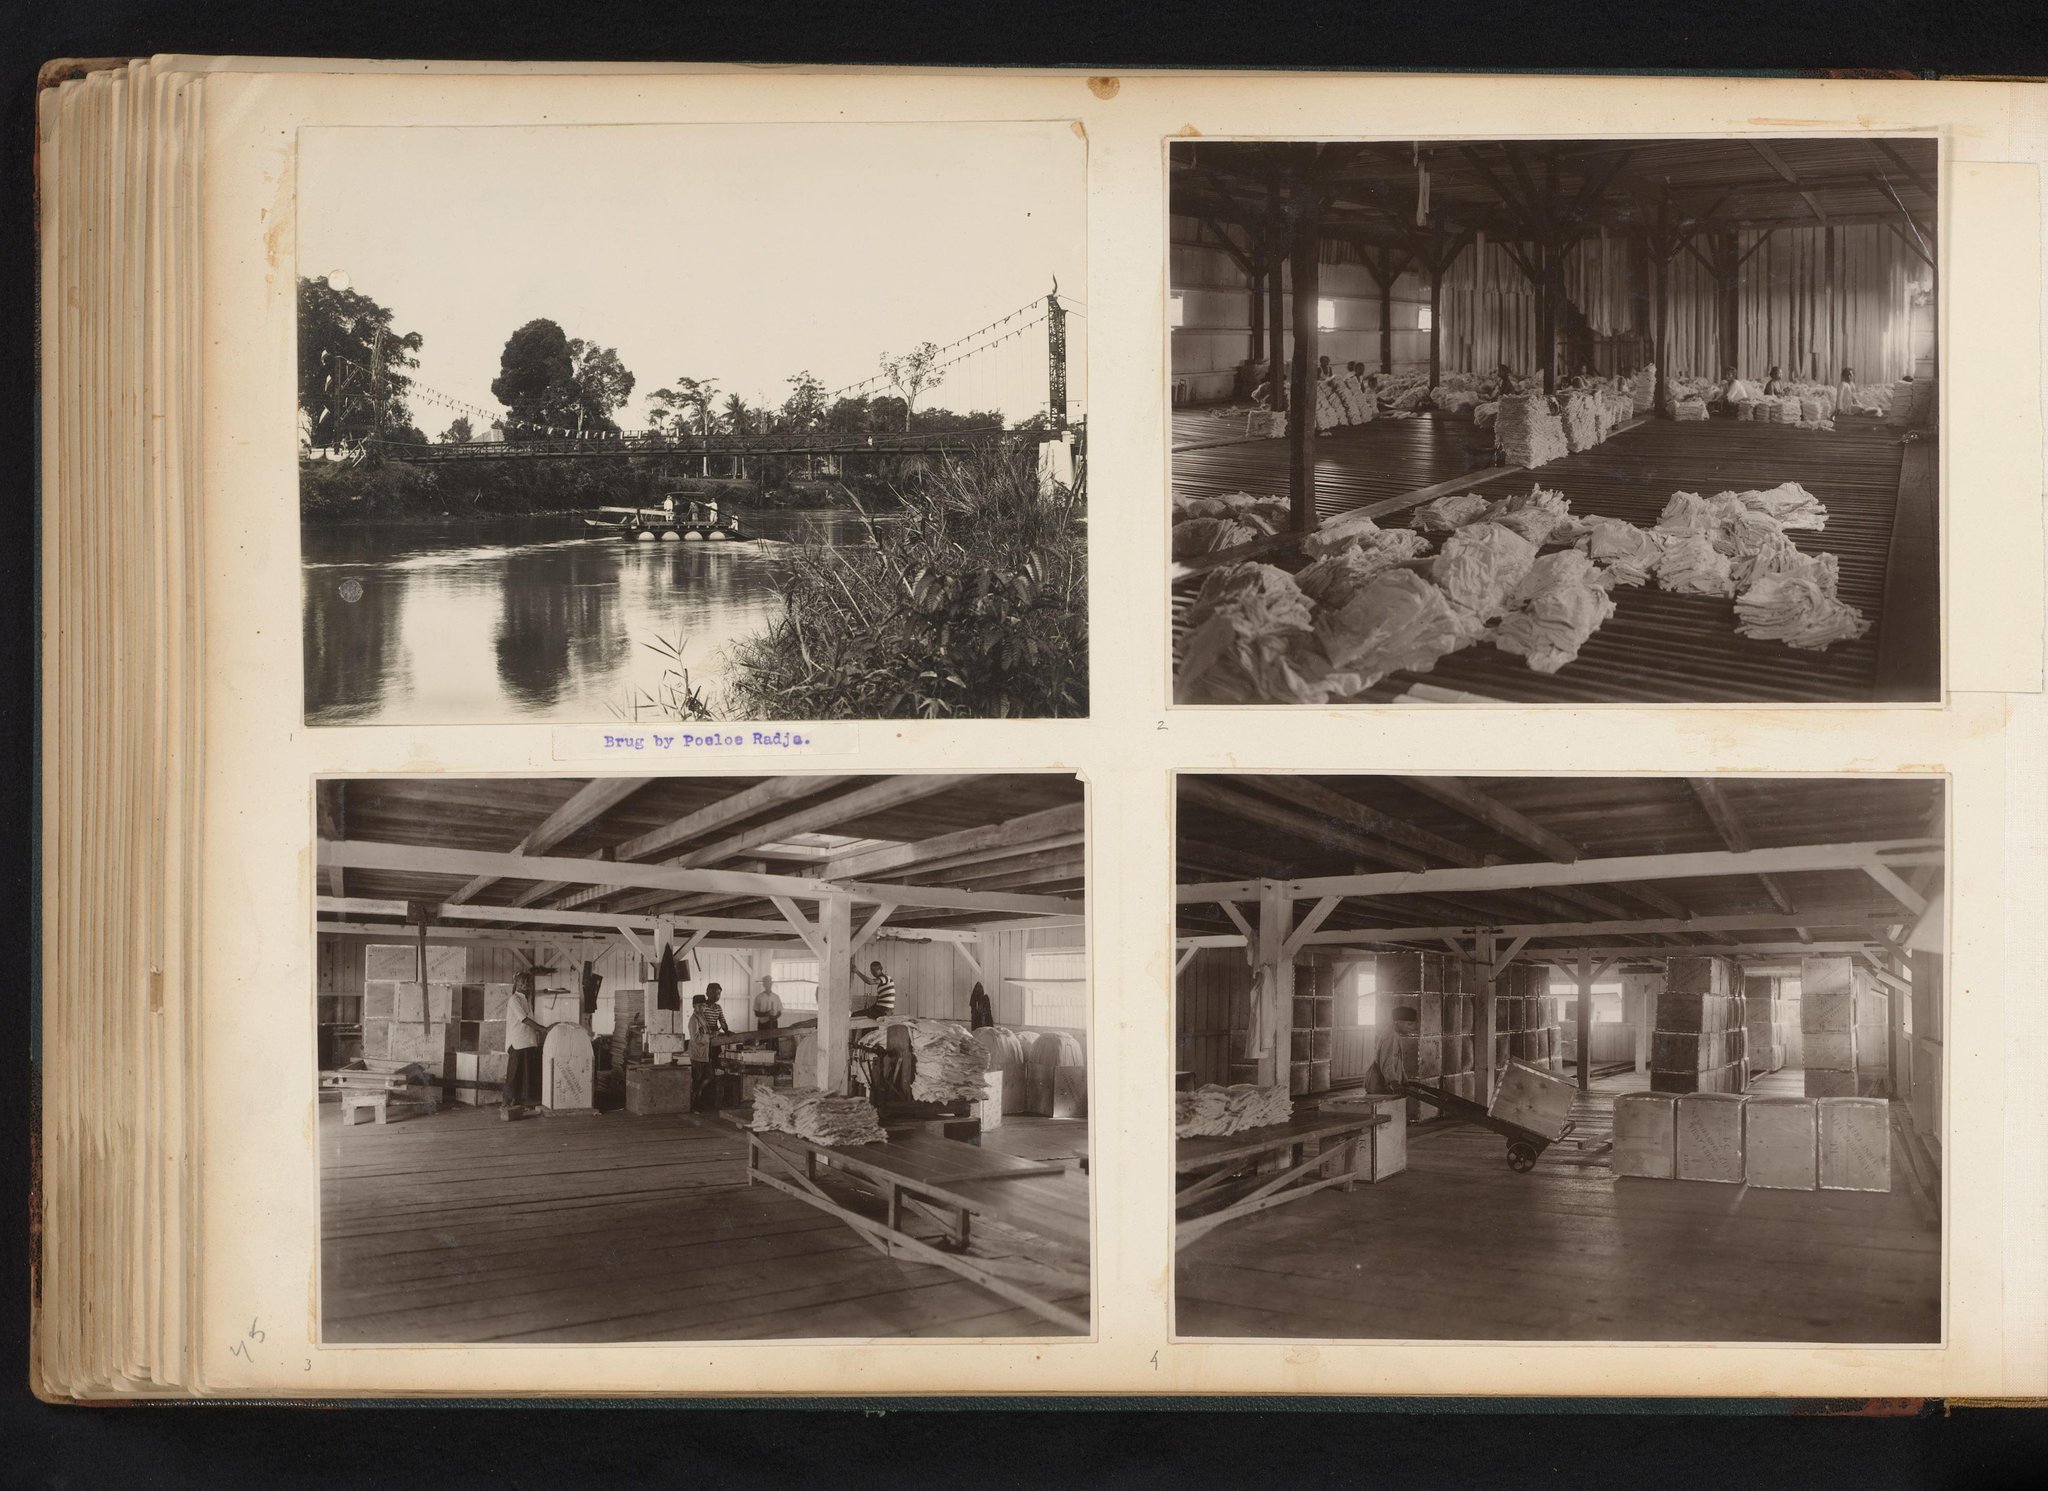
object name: album leaf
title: Brug bij Poeloe Radja en interieur rubberfabriek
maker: Anonymous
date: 1929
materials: cardboard, photographic support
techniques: gelatin silver print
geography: sumatra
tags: plantation, (non-fruit) products of plants or trees: rubber, interior of industrial structures (regardless of the materials processed or the products made, bridge, sumatra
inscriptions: date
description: Blad met vier foto's van de feestelijke opening van de nieuwe brug bij Poeloe Radja (Pulau Raja) op Noord-Sumatra en van het interieur met werknemers van de rubberfabriek op Brussel, 1929. Zonder onderschriften. Onderdeel van het fotoalbum over de plantages Brussel en Pernantian van de Sumatra Caoutchouc Maatschappij op de Oostkust van Sumatra in de jaren 1910-1935.